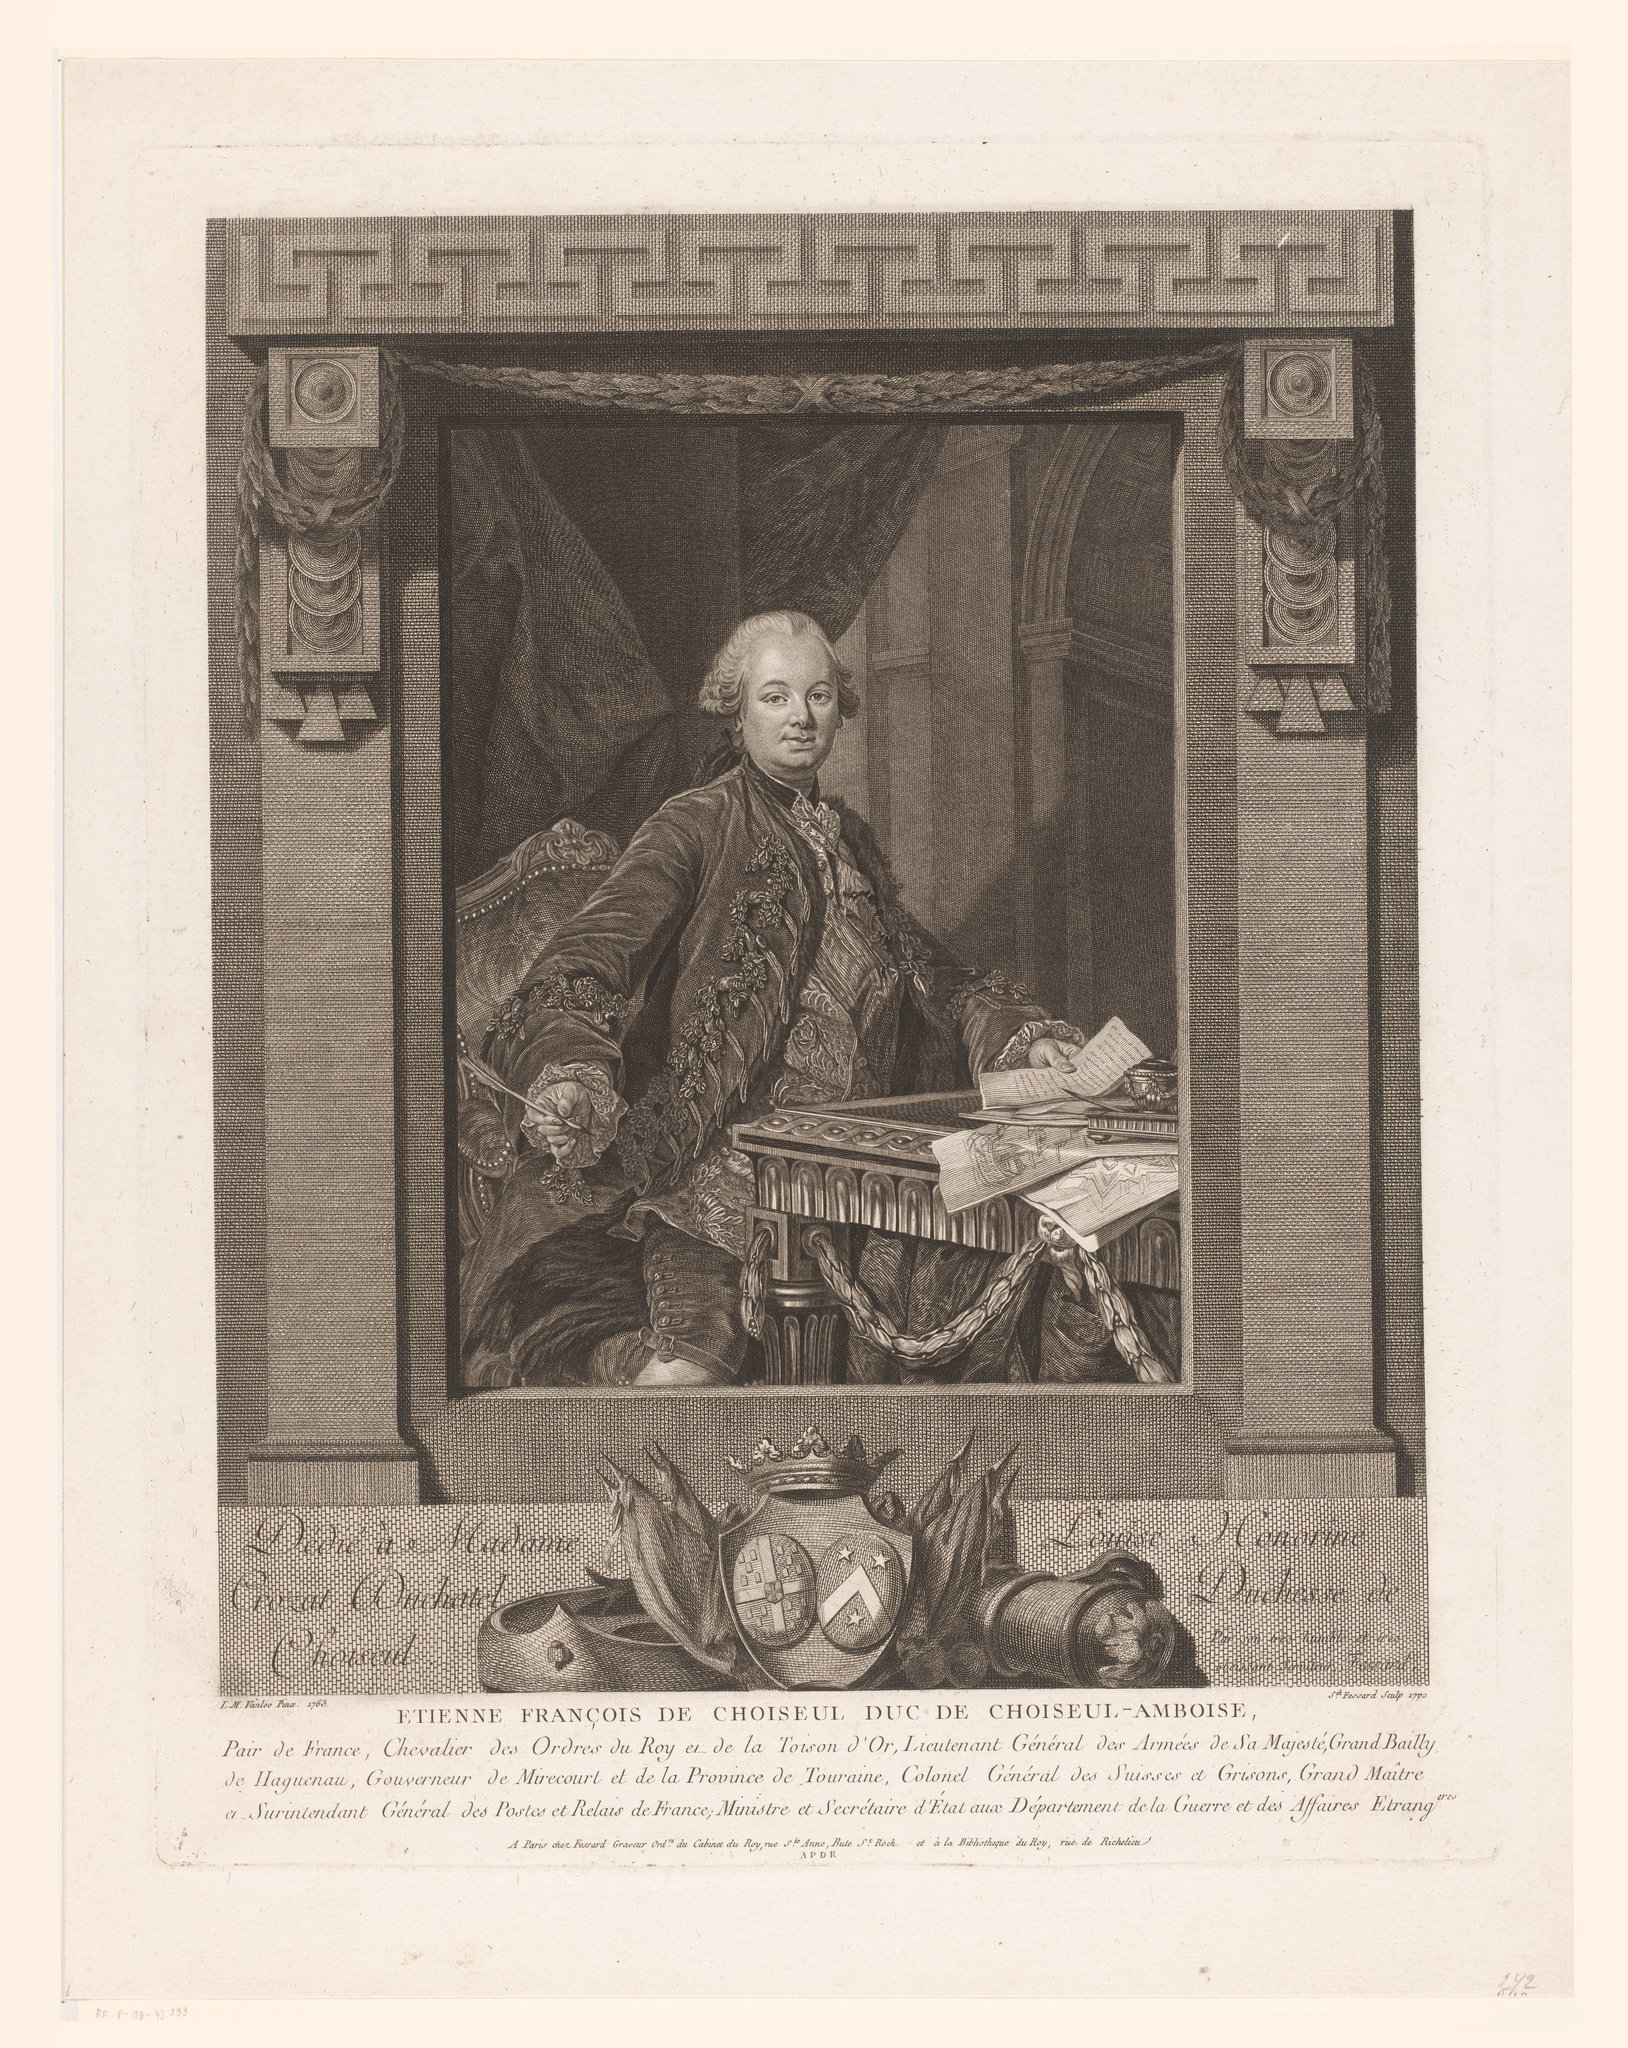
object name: print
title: Portret van Etienne François de Choiseul in architecturale lijst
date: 1770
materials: paper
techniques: engraving, etching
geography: paris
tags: etienne françois de choiseul, mouldings ~ architecture, official; civil servant; functionary (in general), historical persons, diplomacy, diplomat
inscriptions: collector's mark: Lugt 240